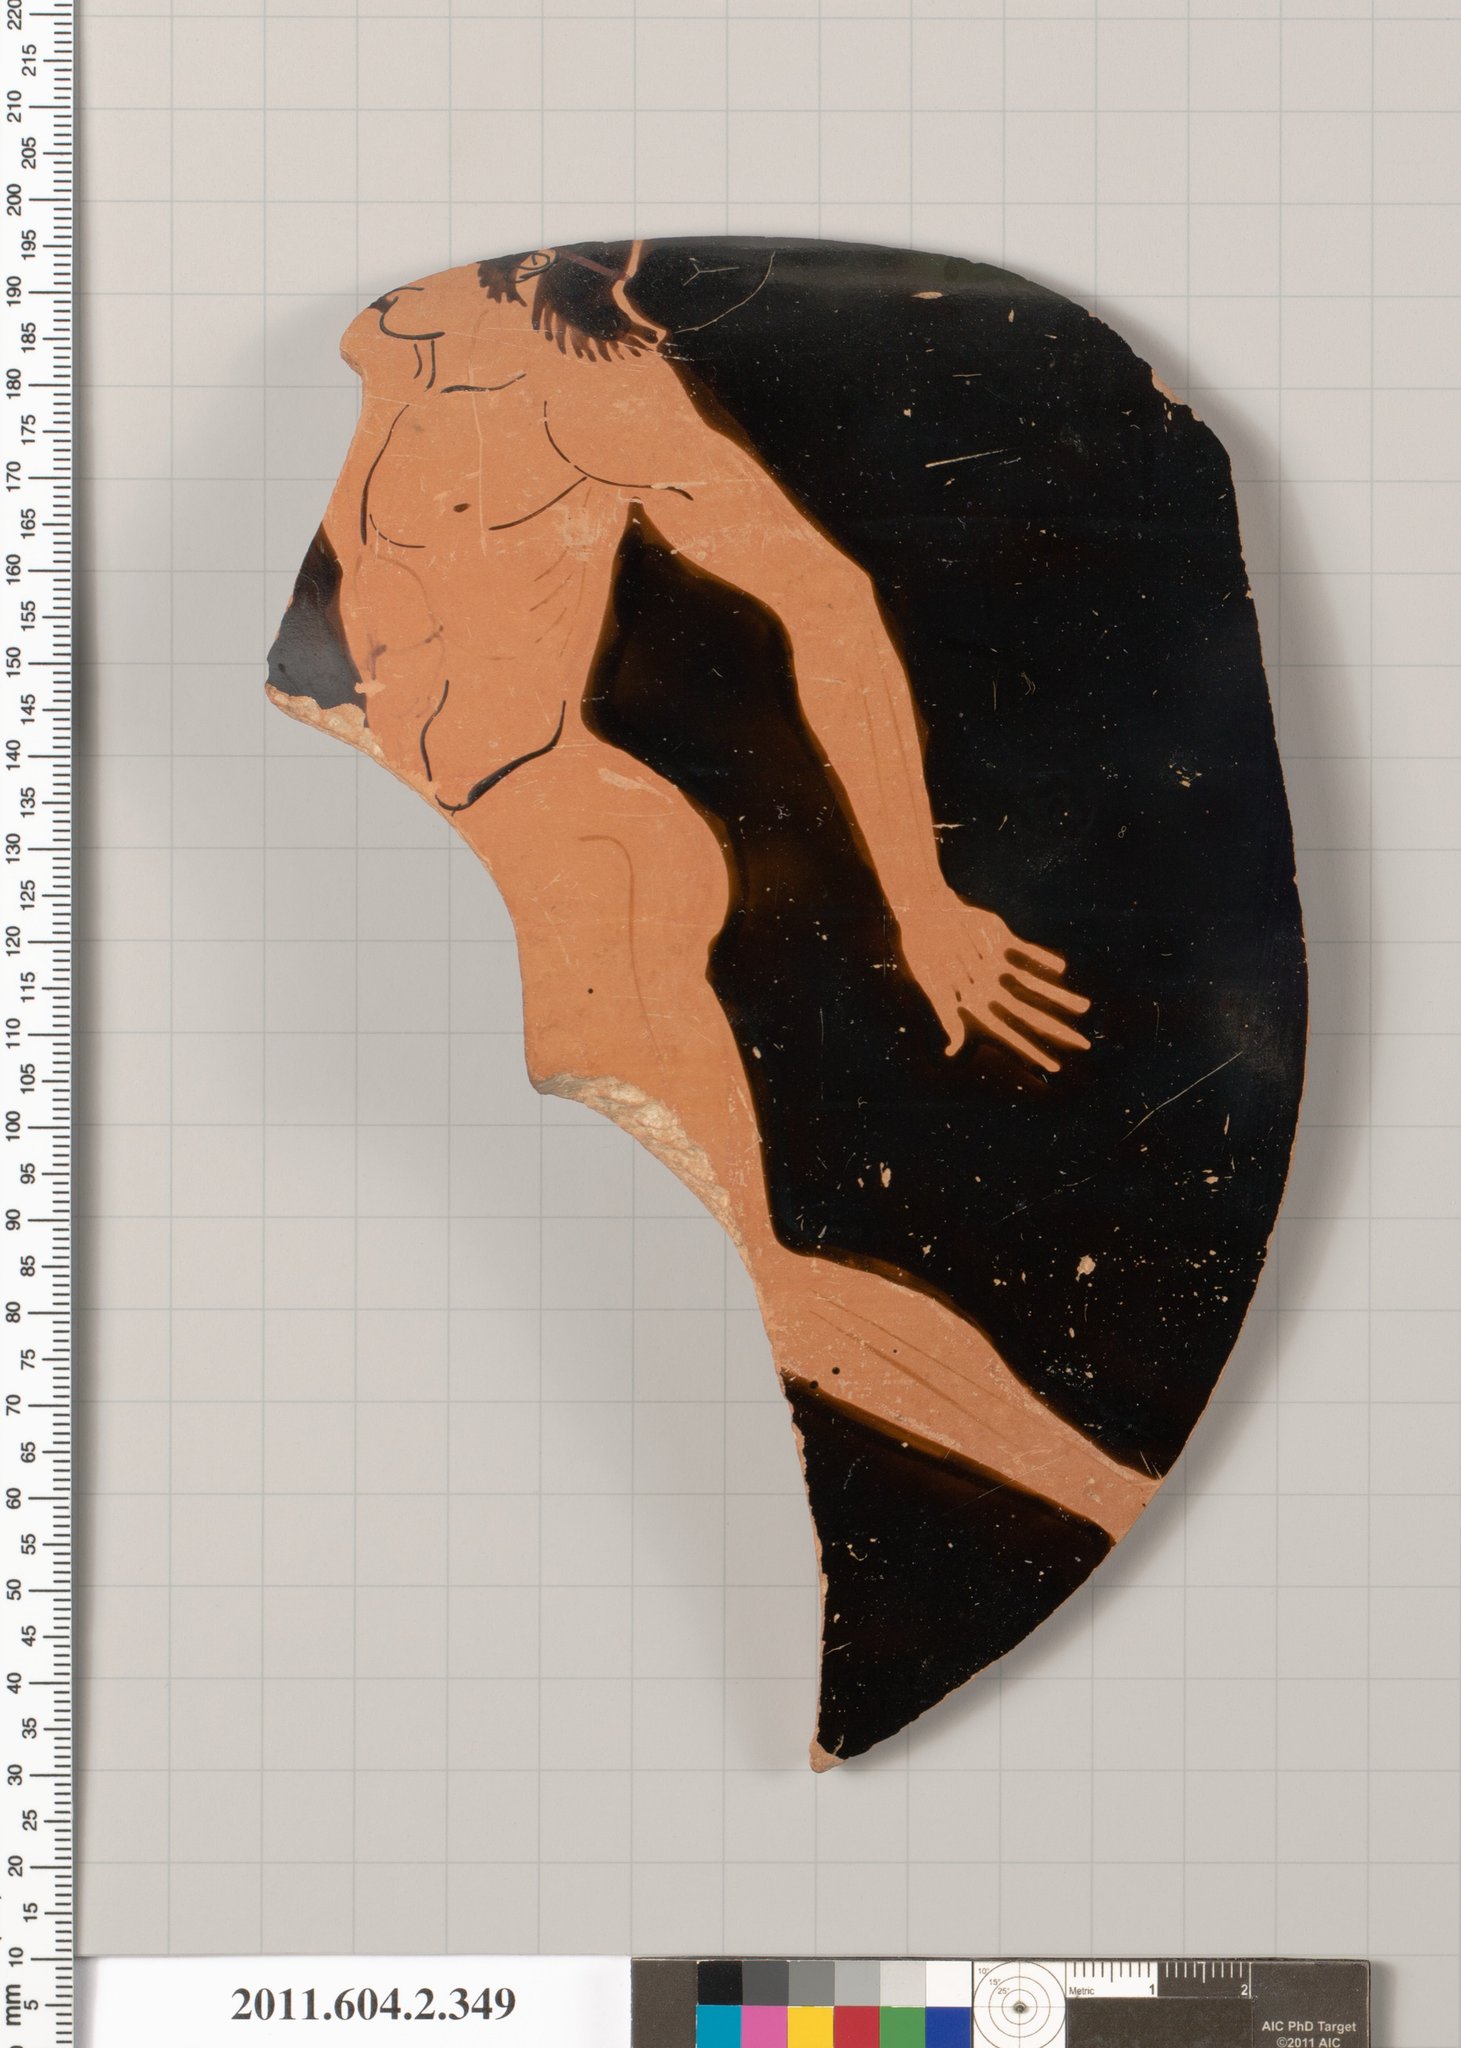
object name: column krater fragment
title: Terracotta fragment of a column-krater (bowl for mixing wine and water)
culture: greek, attic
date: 460-440 BCE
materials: terracotta